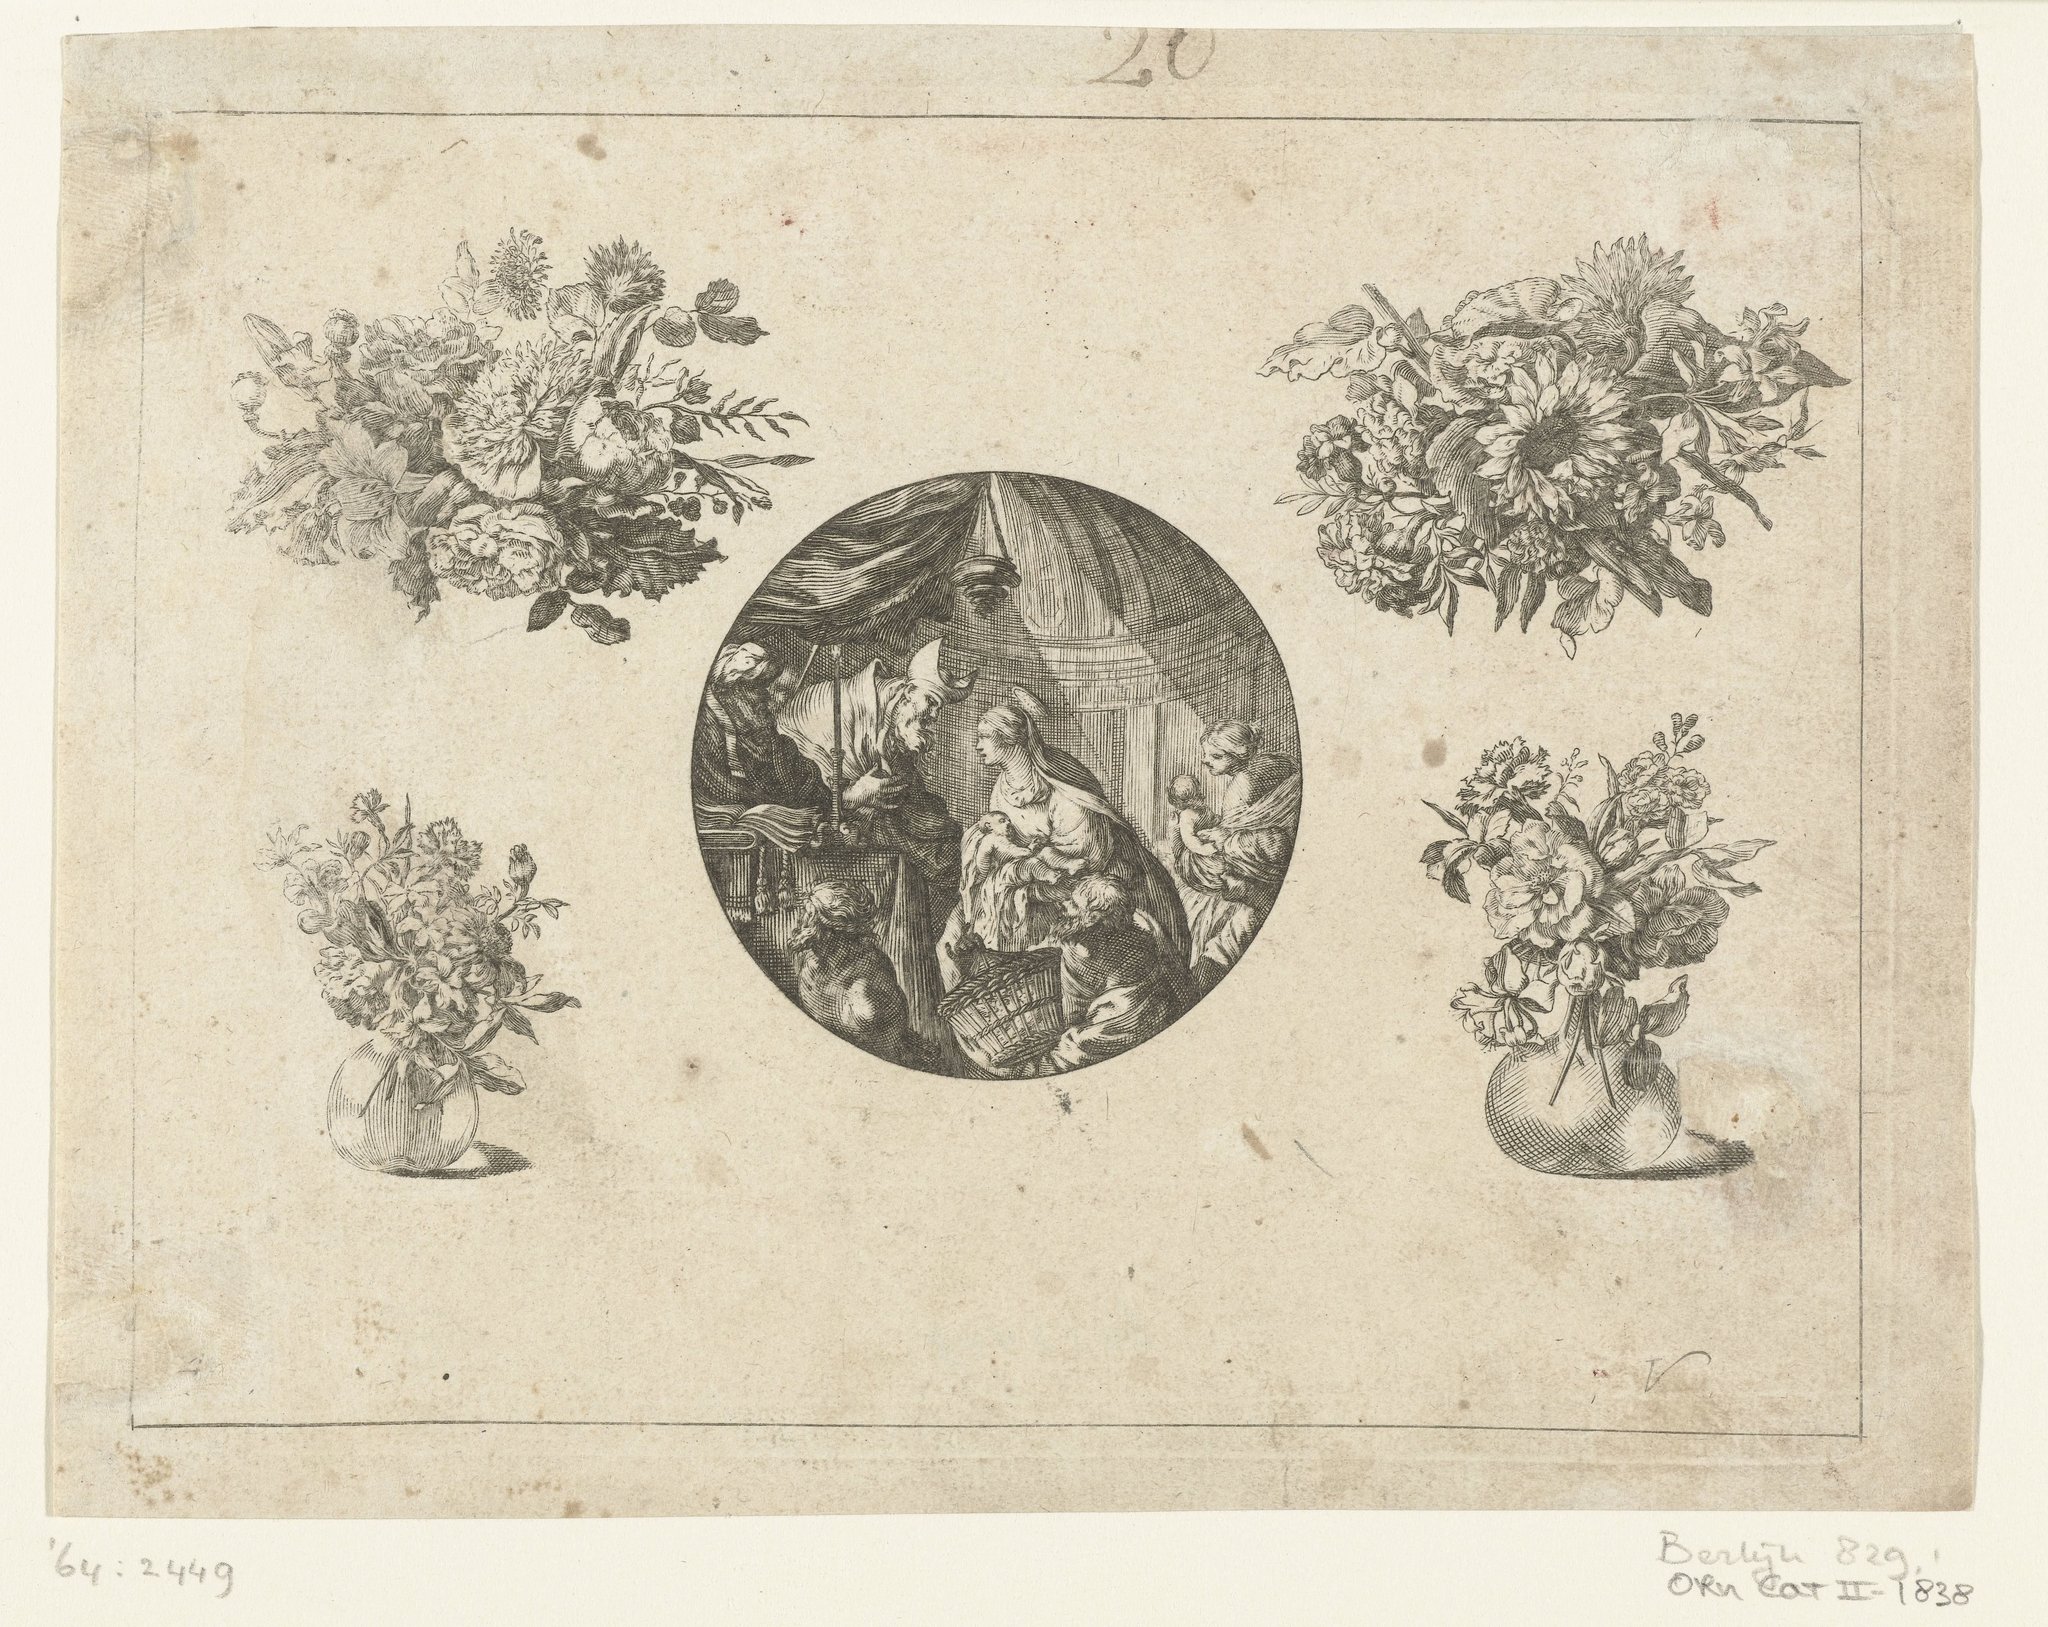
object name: print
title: Edelsmidsontwerpen voor horlogekasten: deksels en zijkanten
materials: paper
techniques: engraving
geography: france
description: Horlogekast met de Presentatie van Christus in de Tempel. Eerste editie, tweede druk.